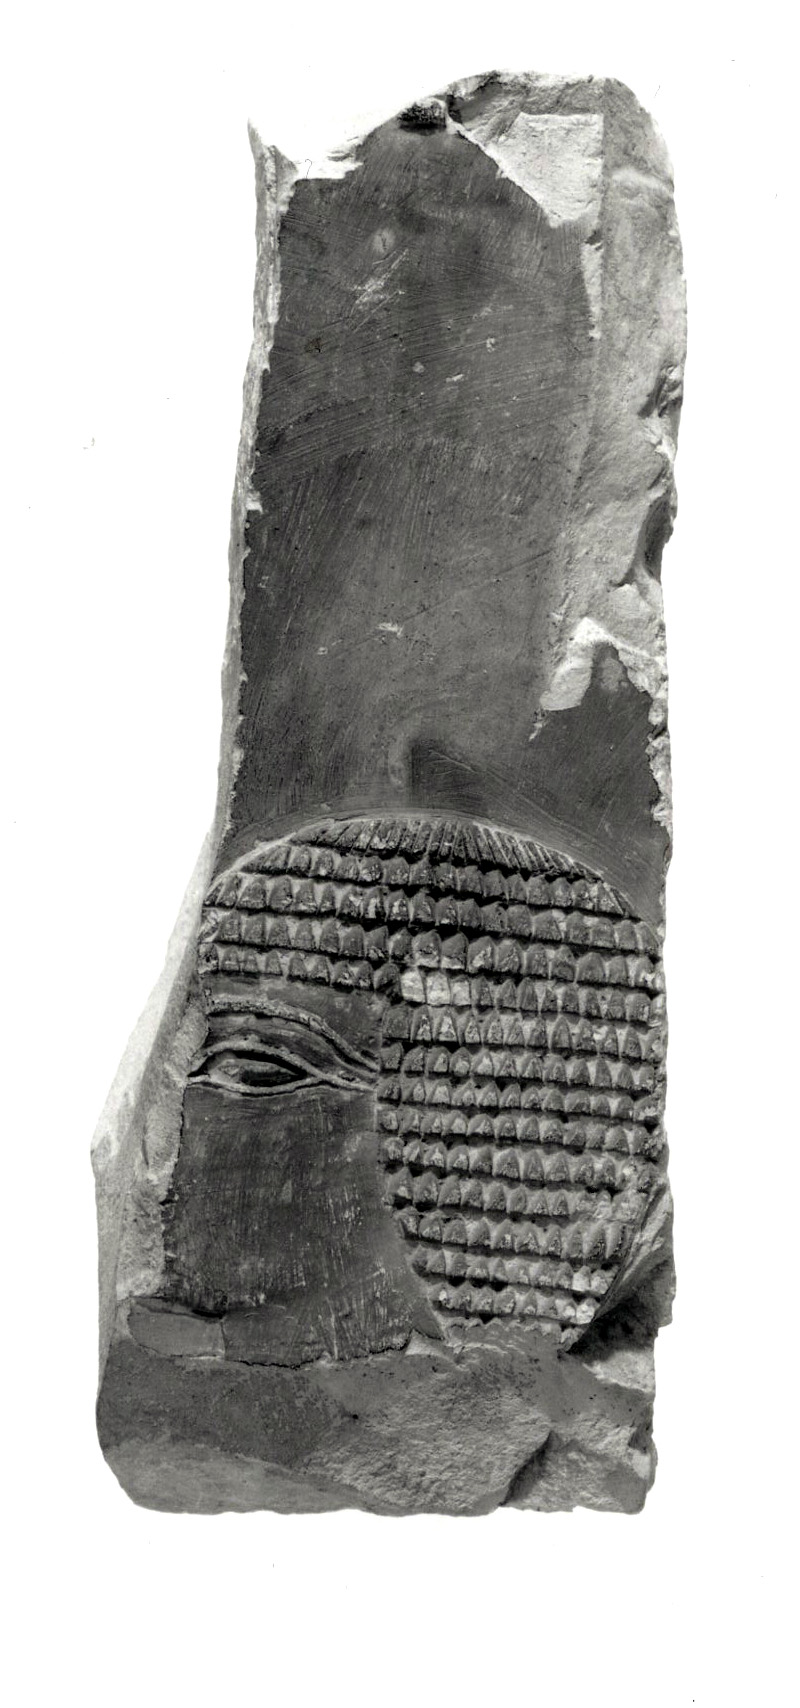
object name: relief, tomb of nespekashuty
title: Raised relief fragment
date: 664-610 BCE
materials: limestone, varnish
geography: egypt